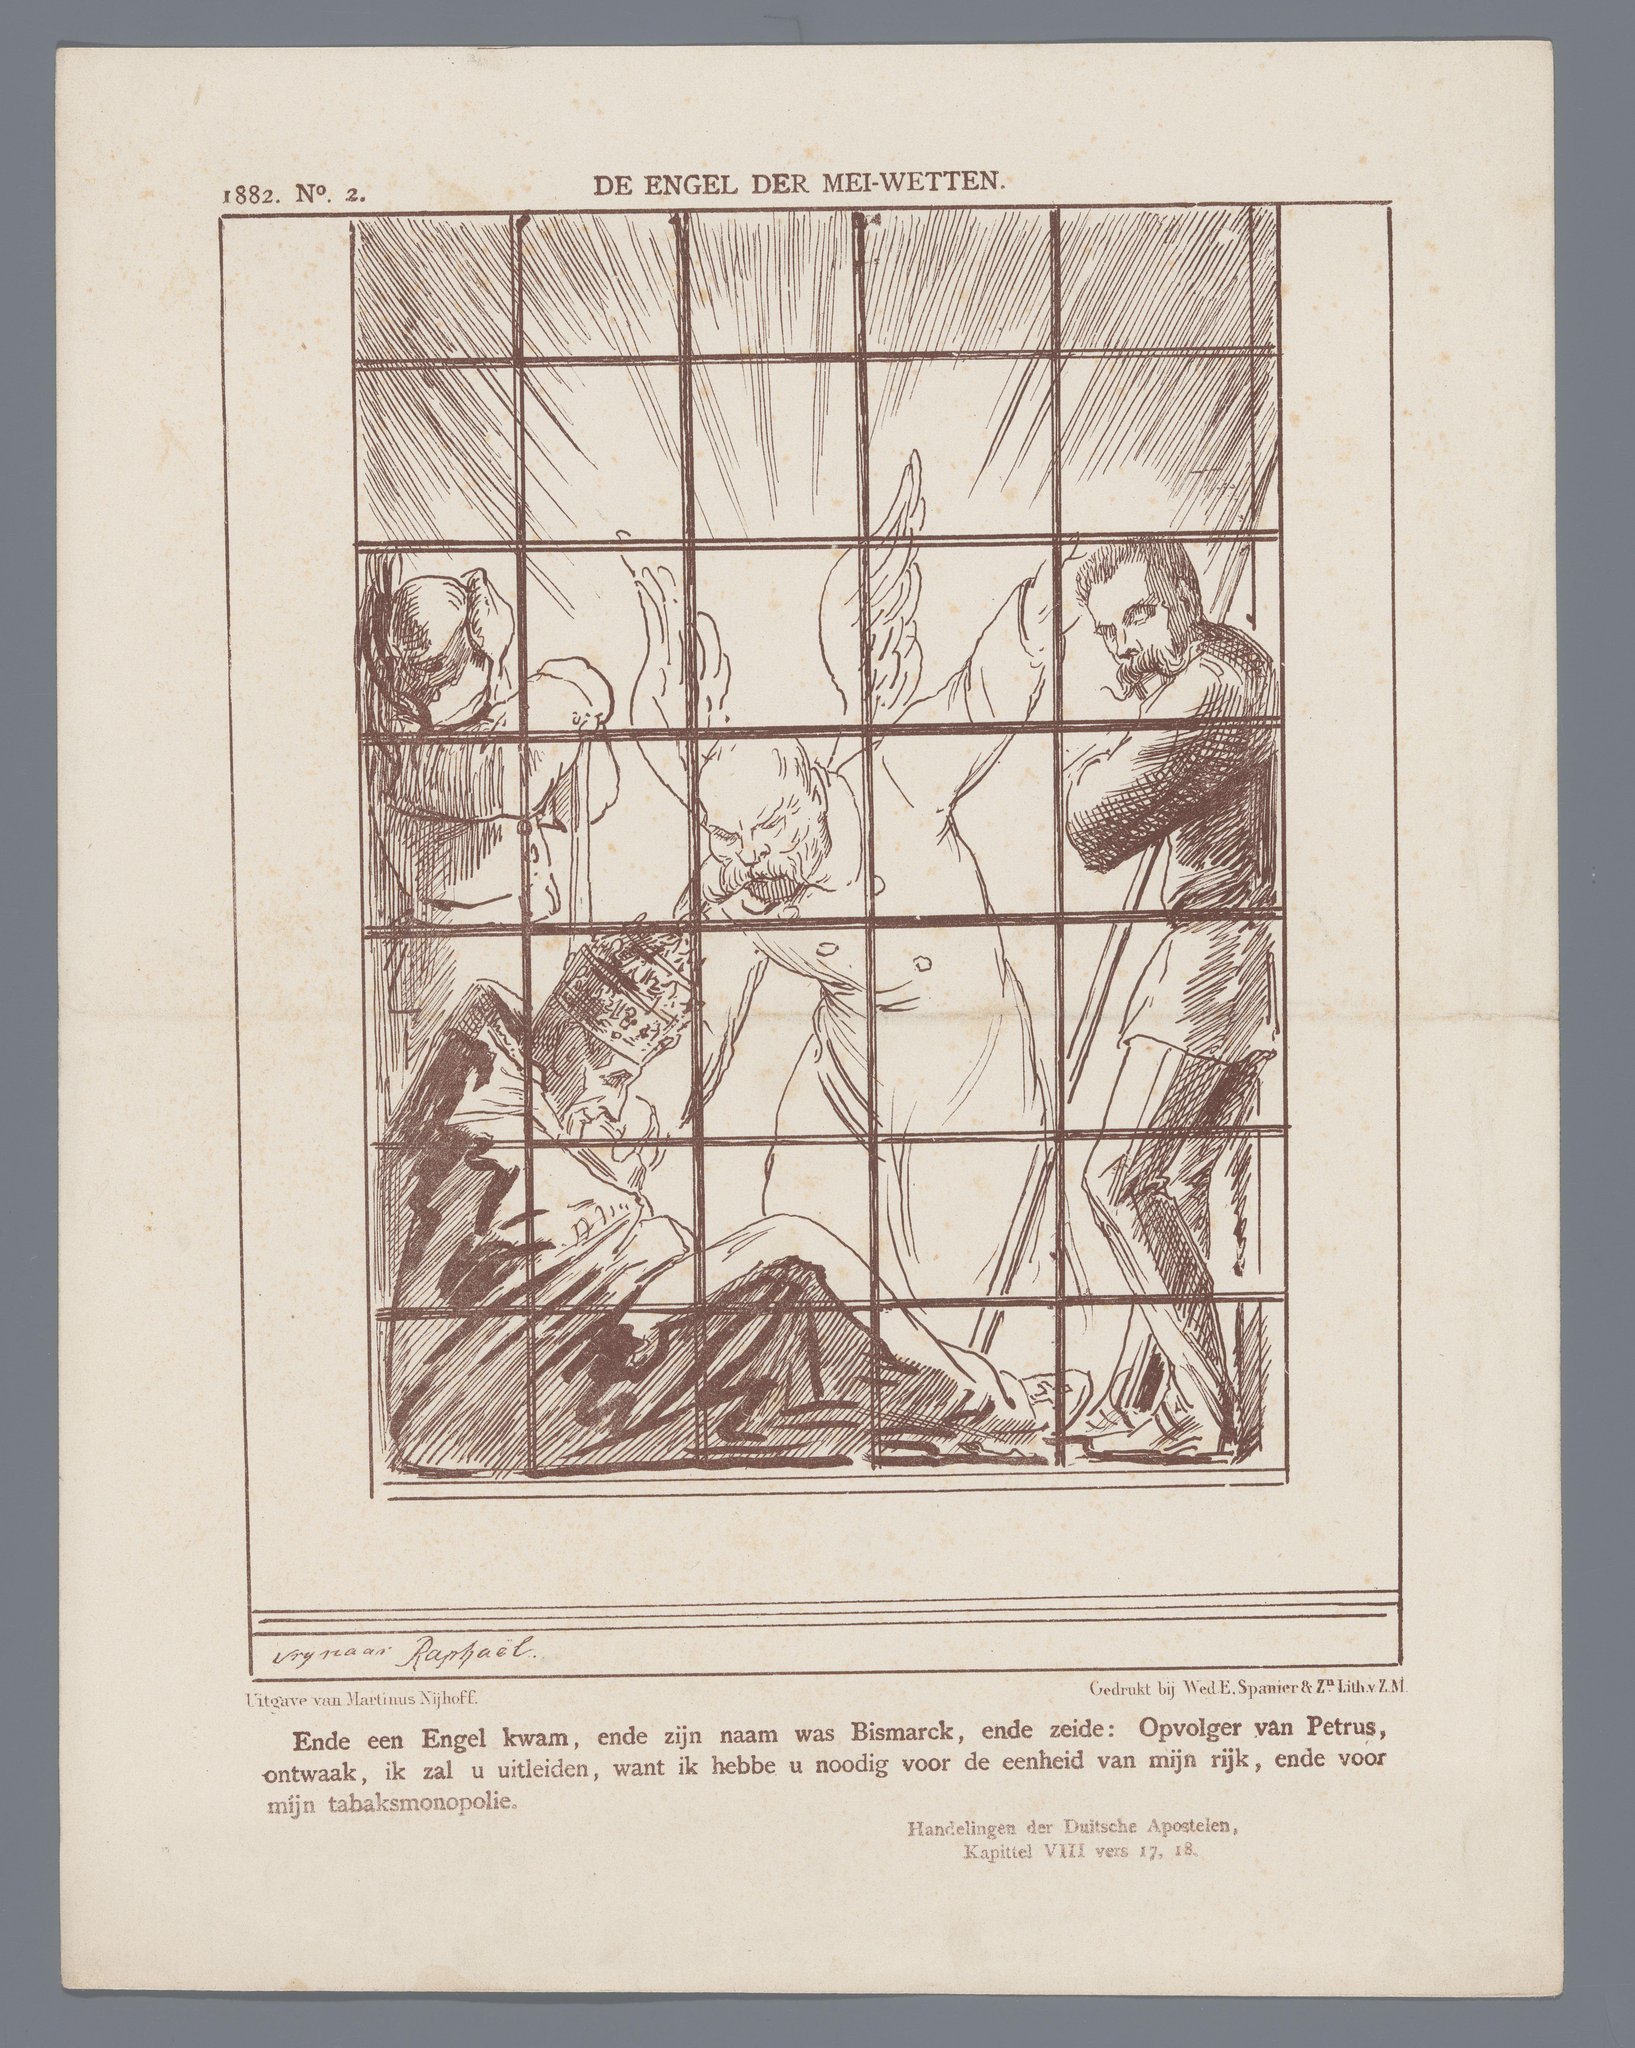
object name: cartoon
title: De engel der Mei-wetten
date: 1882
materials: paper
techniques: lithograph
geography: netherlands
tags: schönhausen, friedrichsruh, staatsman, otto von bismarck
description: Politieke spotprent met Bismarck als engel bij de paus. Plaat verschenen bij het weekblad De Nederlandsche Spectator, nr. 2, 1882.